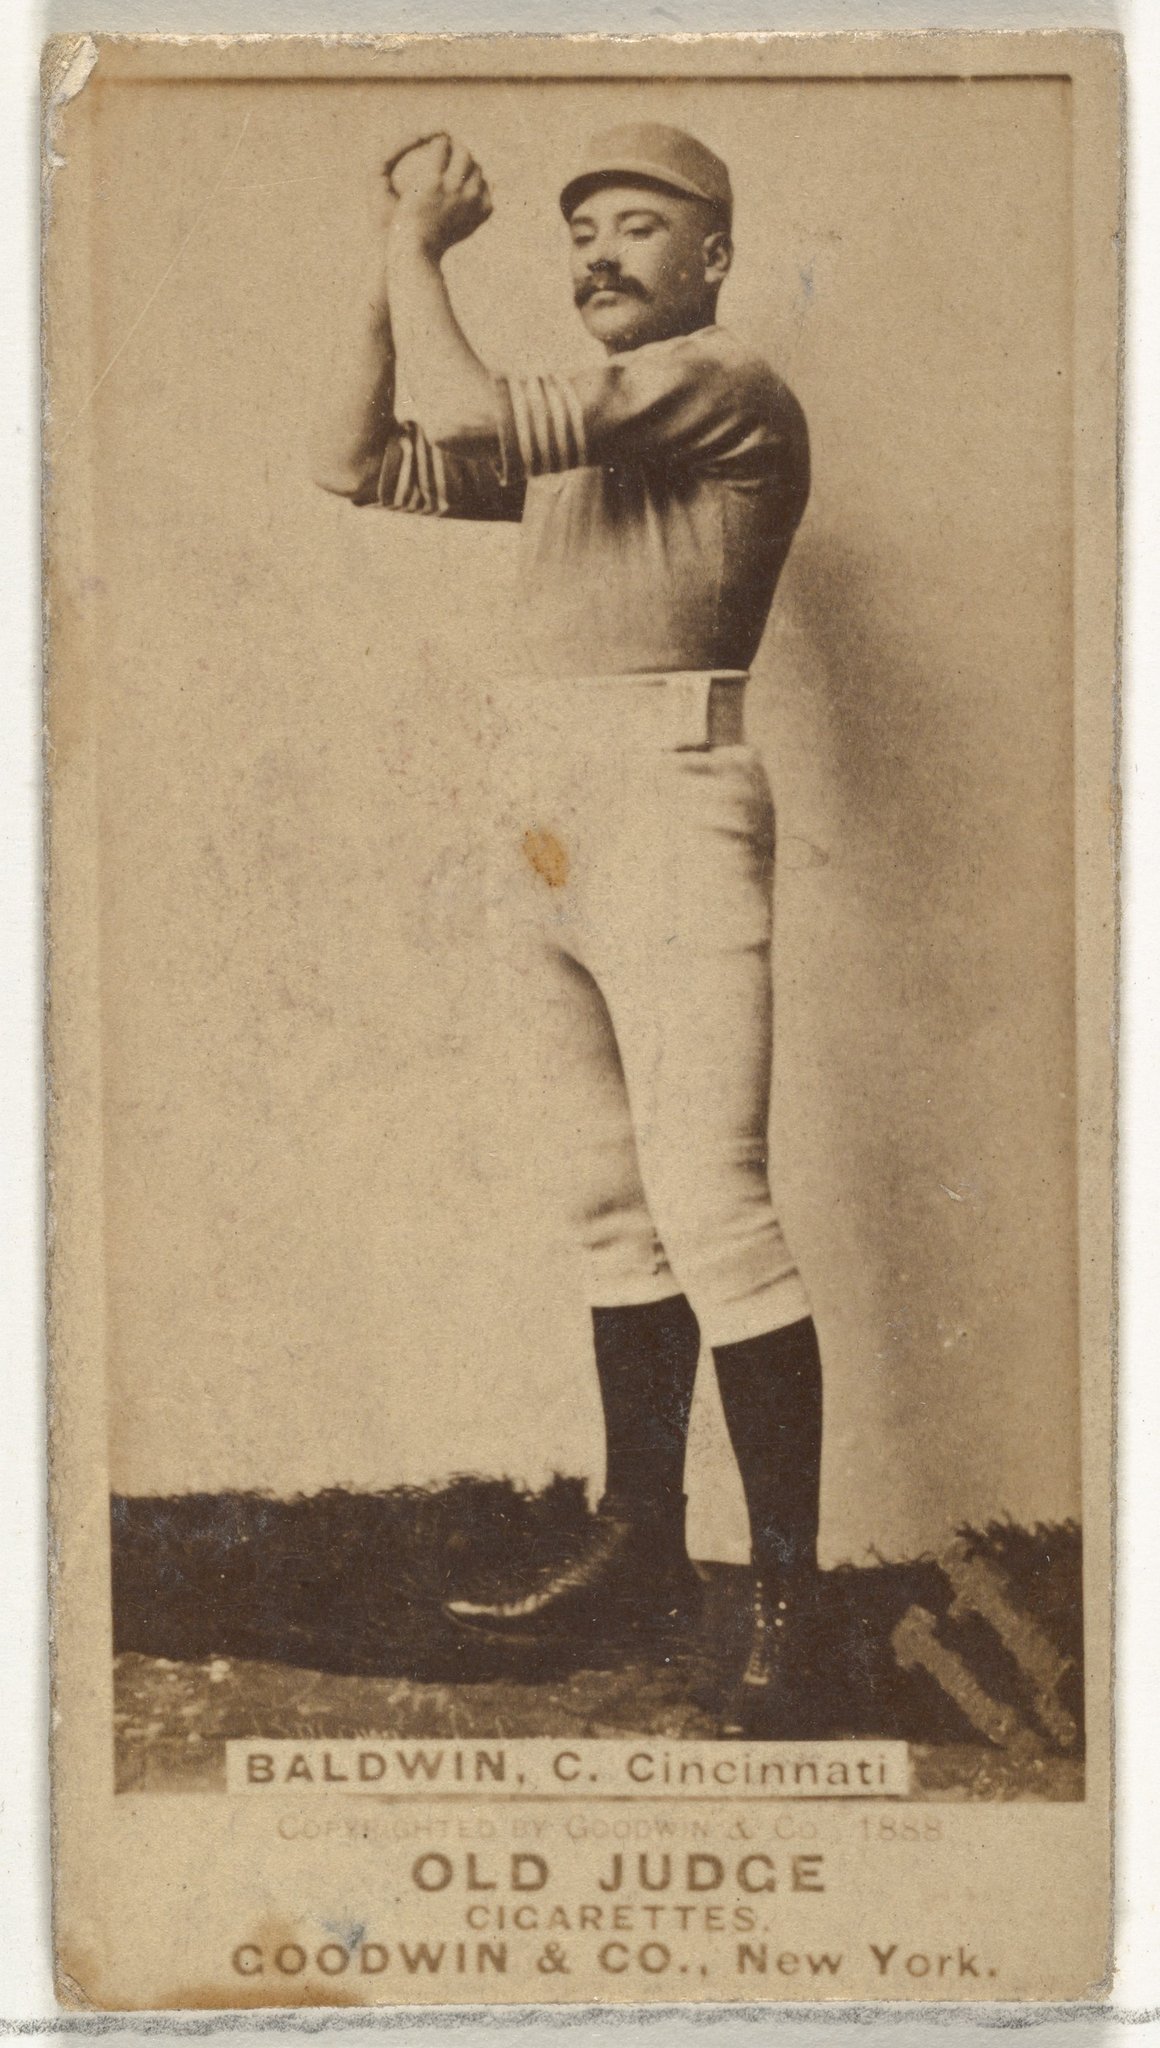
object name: baseball card, photograph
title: Clarence Geoghan "Kid" Baldwin, Catcher, Cincinnati, from the Old Judge series (N172) for Old Judge Cigarettes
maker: goodwin & company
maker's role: publisher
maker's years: 1850-1950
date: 1888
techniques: albumen silver print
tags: men,portraits,baseball,athletes